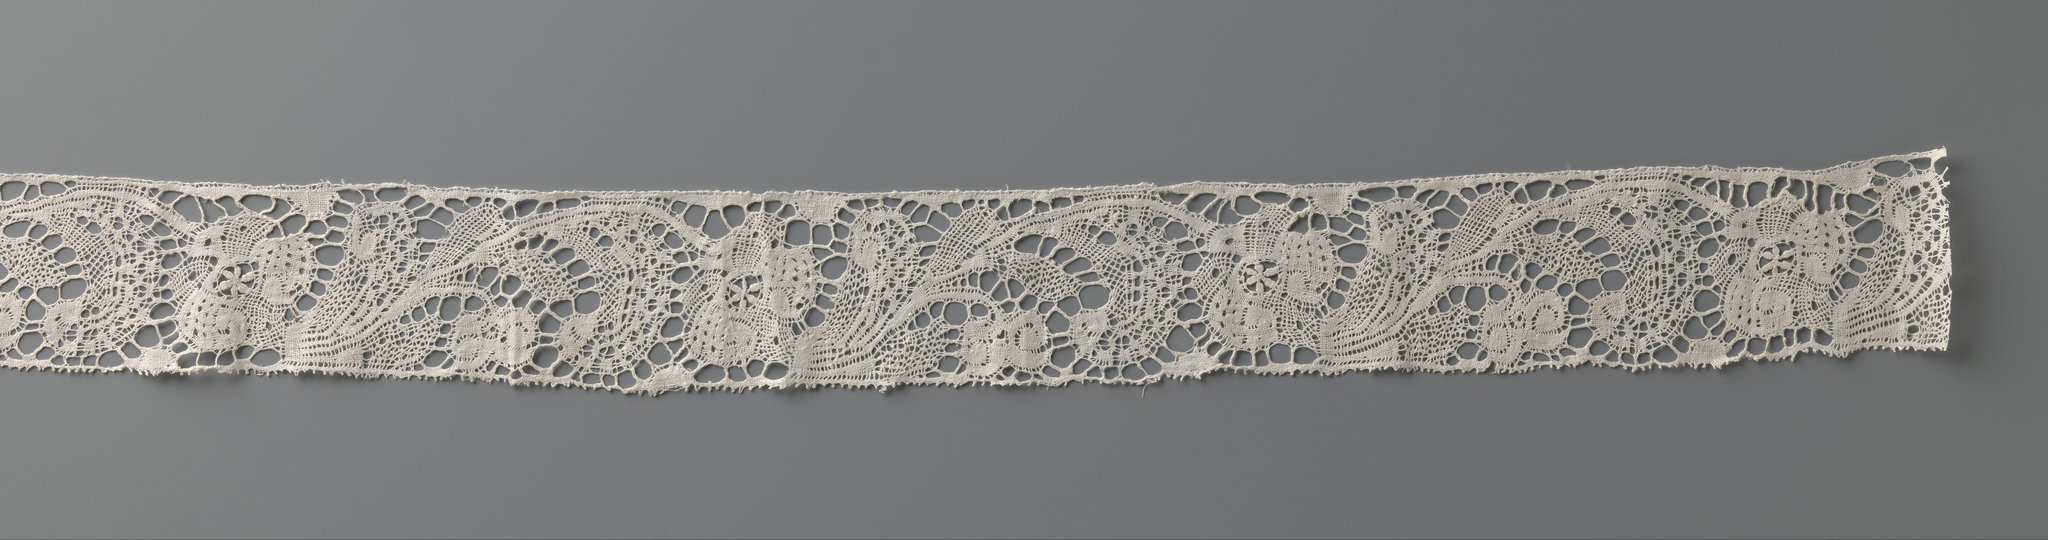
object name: strip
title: Strook kloskant met aaneengeschakelde gebogen bloemstengels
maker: Anonymous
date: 1650-1699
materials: linen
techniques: lace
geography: southern netherlands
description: Tussenzetsel van naturelkleurige kloskant: oudvlaamse kloskant met vlechtengrond. Het zich herhalende patroon bestaat uit een aaneenschakeling van steeds eenzelfde gebogen bloemstengel, die onderaan de strook begint en met een boog langs de bovenzijde loopt en eindigt in een grote rozetbloem. De motieven zijn deels gemaakt in linnenslag met opengewerkte randjes en uitsparingen. Enkele (bloem)bladeren zijn gemaakt in vetergatslag en andere bladeren zijn gevormd door een sneeuwvlokkengrond of spinnengrond. De bloemharten van de grote rozetbloemen zijn voorzien van een zespuntige ster gemaakt in vormslag. De motieven zijn met elkaar verbonden door een vlechtengrond met lange vlechten. Boven- en onderzijde van de strook zijn recht afgewerkt waarbij de onderzijde is voorzien van picots.